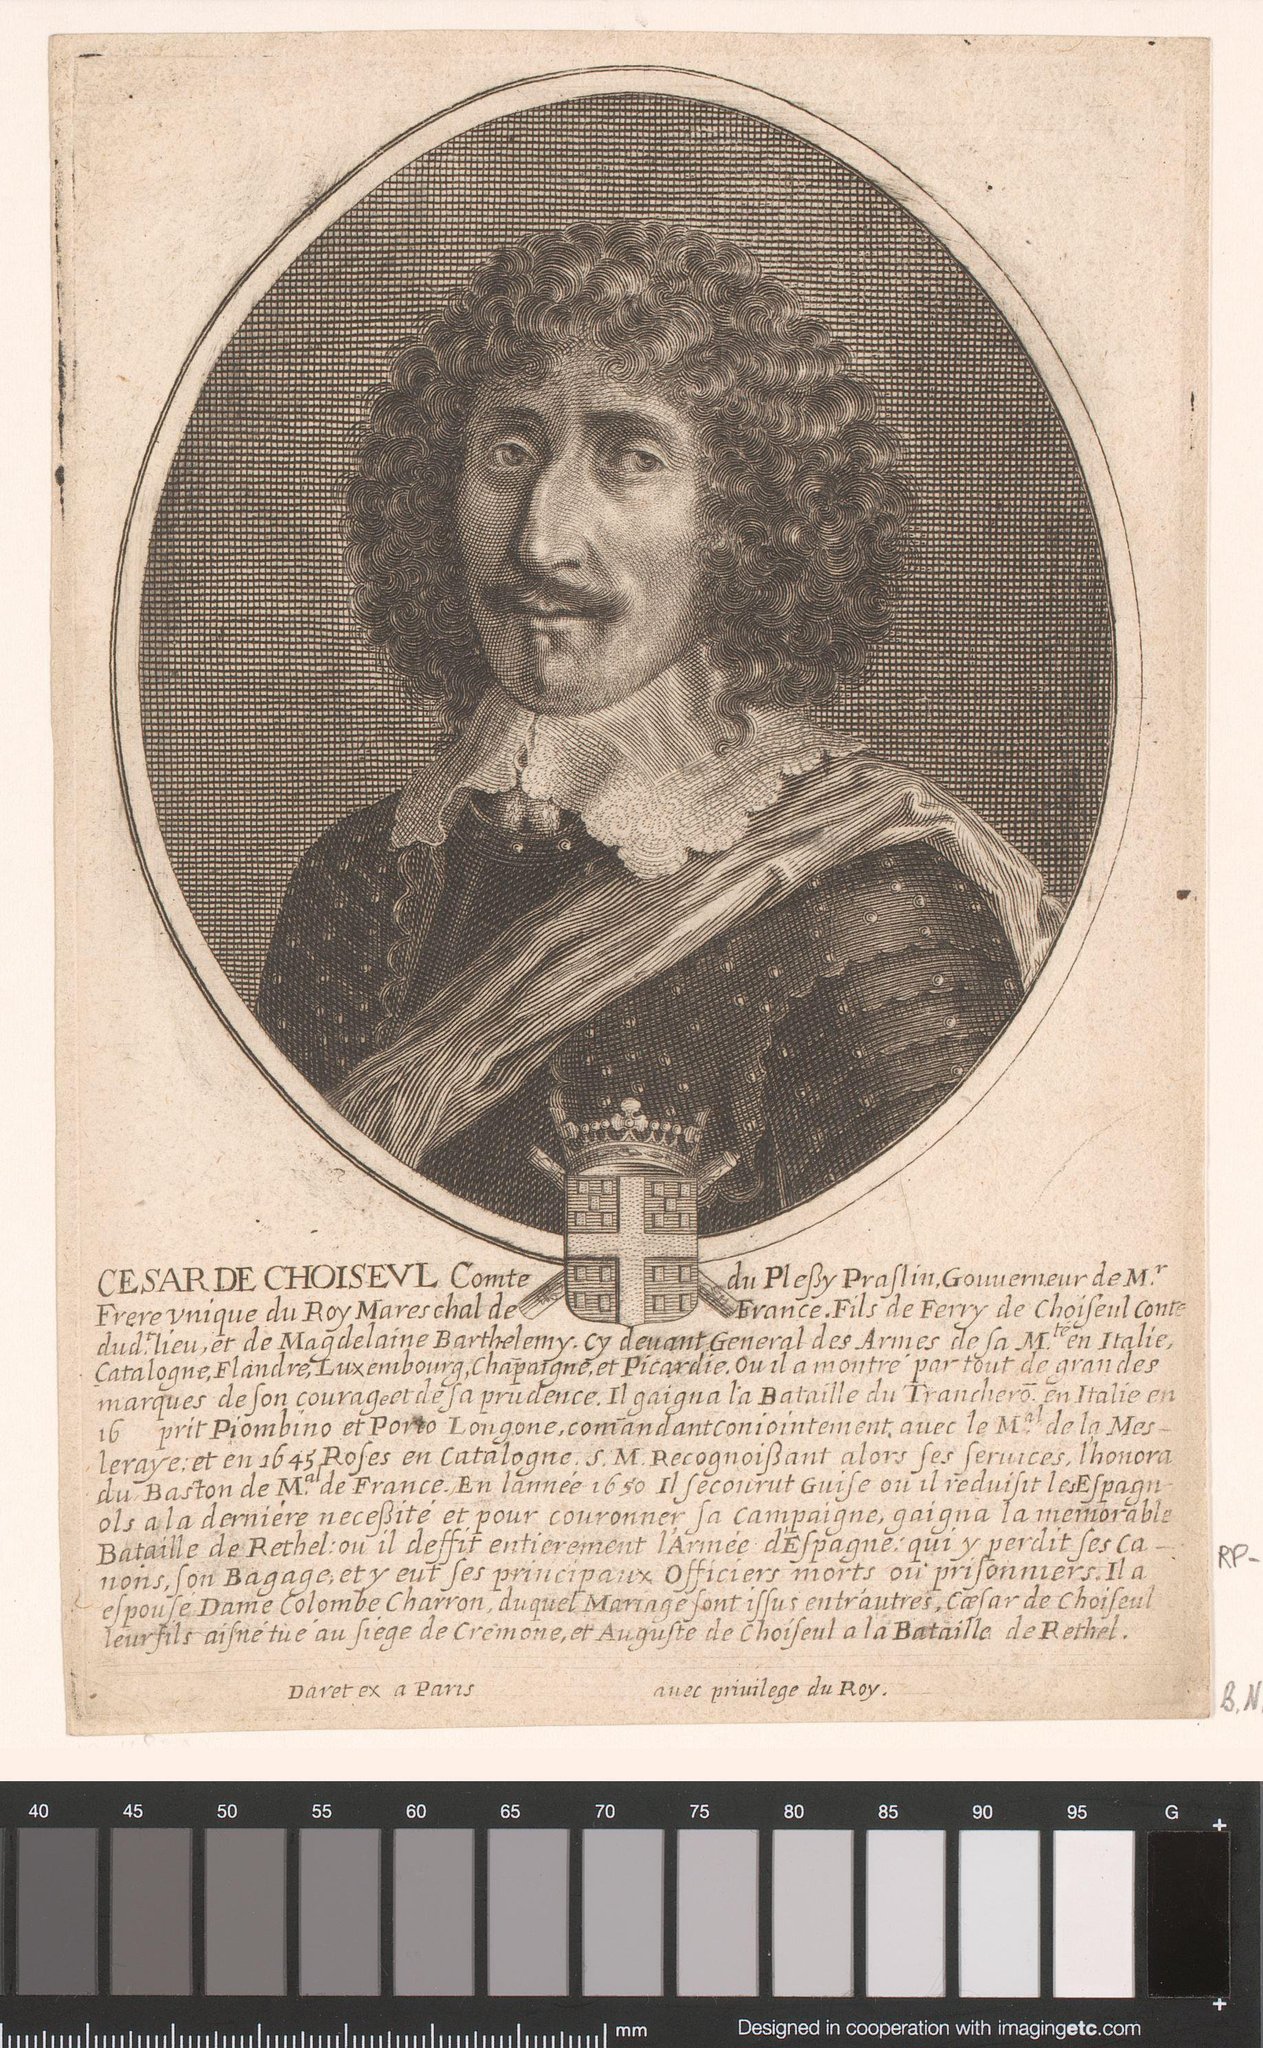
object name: print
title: Portretten van bekende historische figuren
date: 1654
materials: paper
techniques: engraving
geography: paris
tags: historical persons, armorial bearing, heraldry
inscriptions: collector's mark: Lugt 2228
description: Maakt deel uit van een serie portretten getiteld 'Tableaux historiques ou sont gravez les Illustres François et Etrangiers de l'un et l'autre sexe (...)', voor het eerst uitgegeven in 1652 door Daret. Een tweede staat werd uitgegeven door Boissevin en een derde door Jollain.